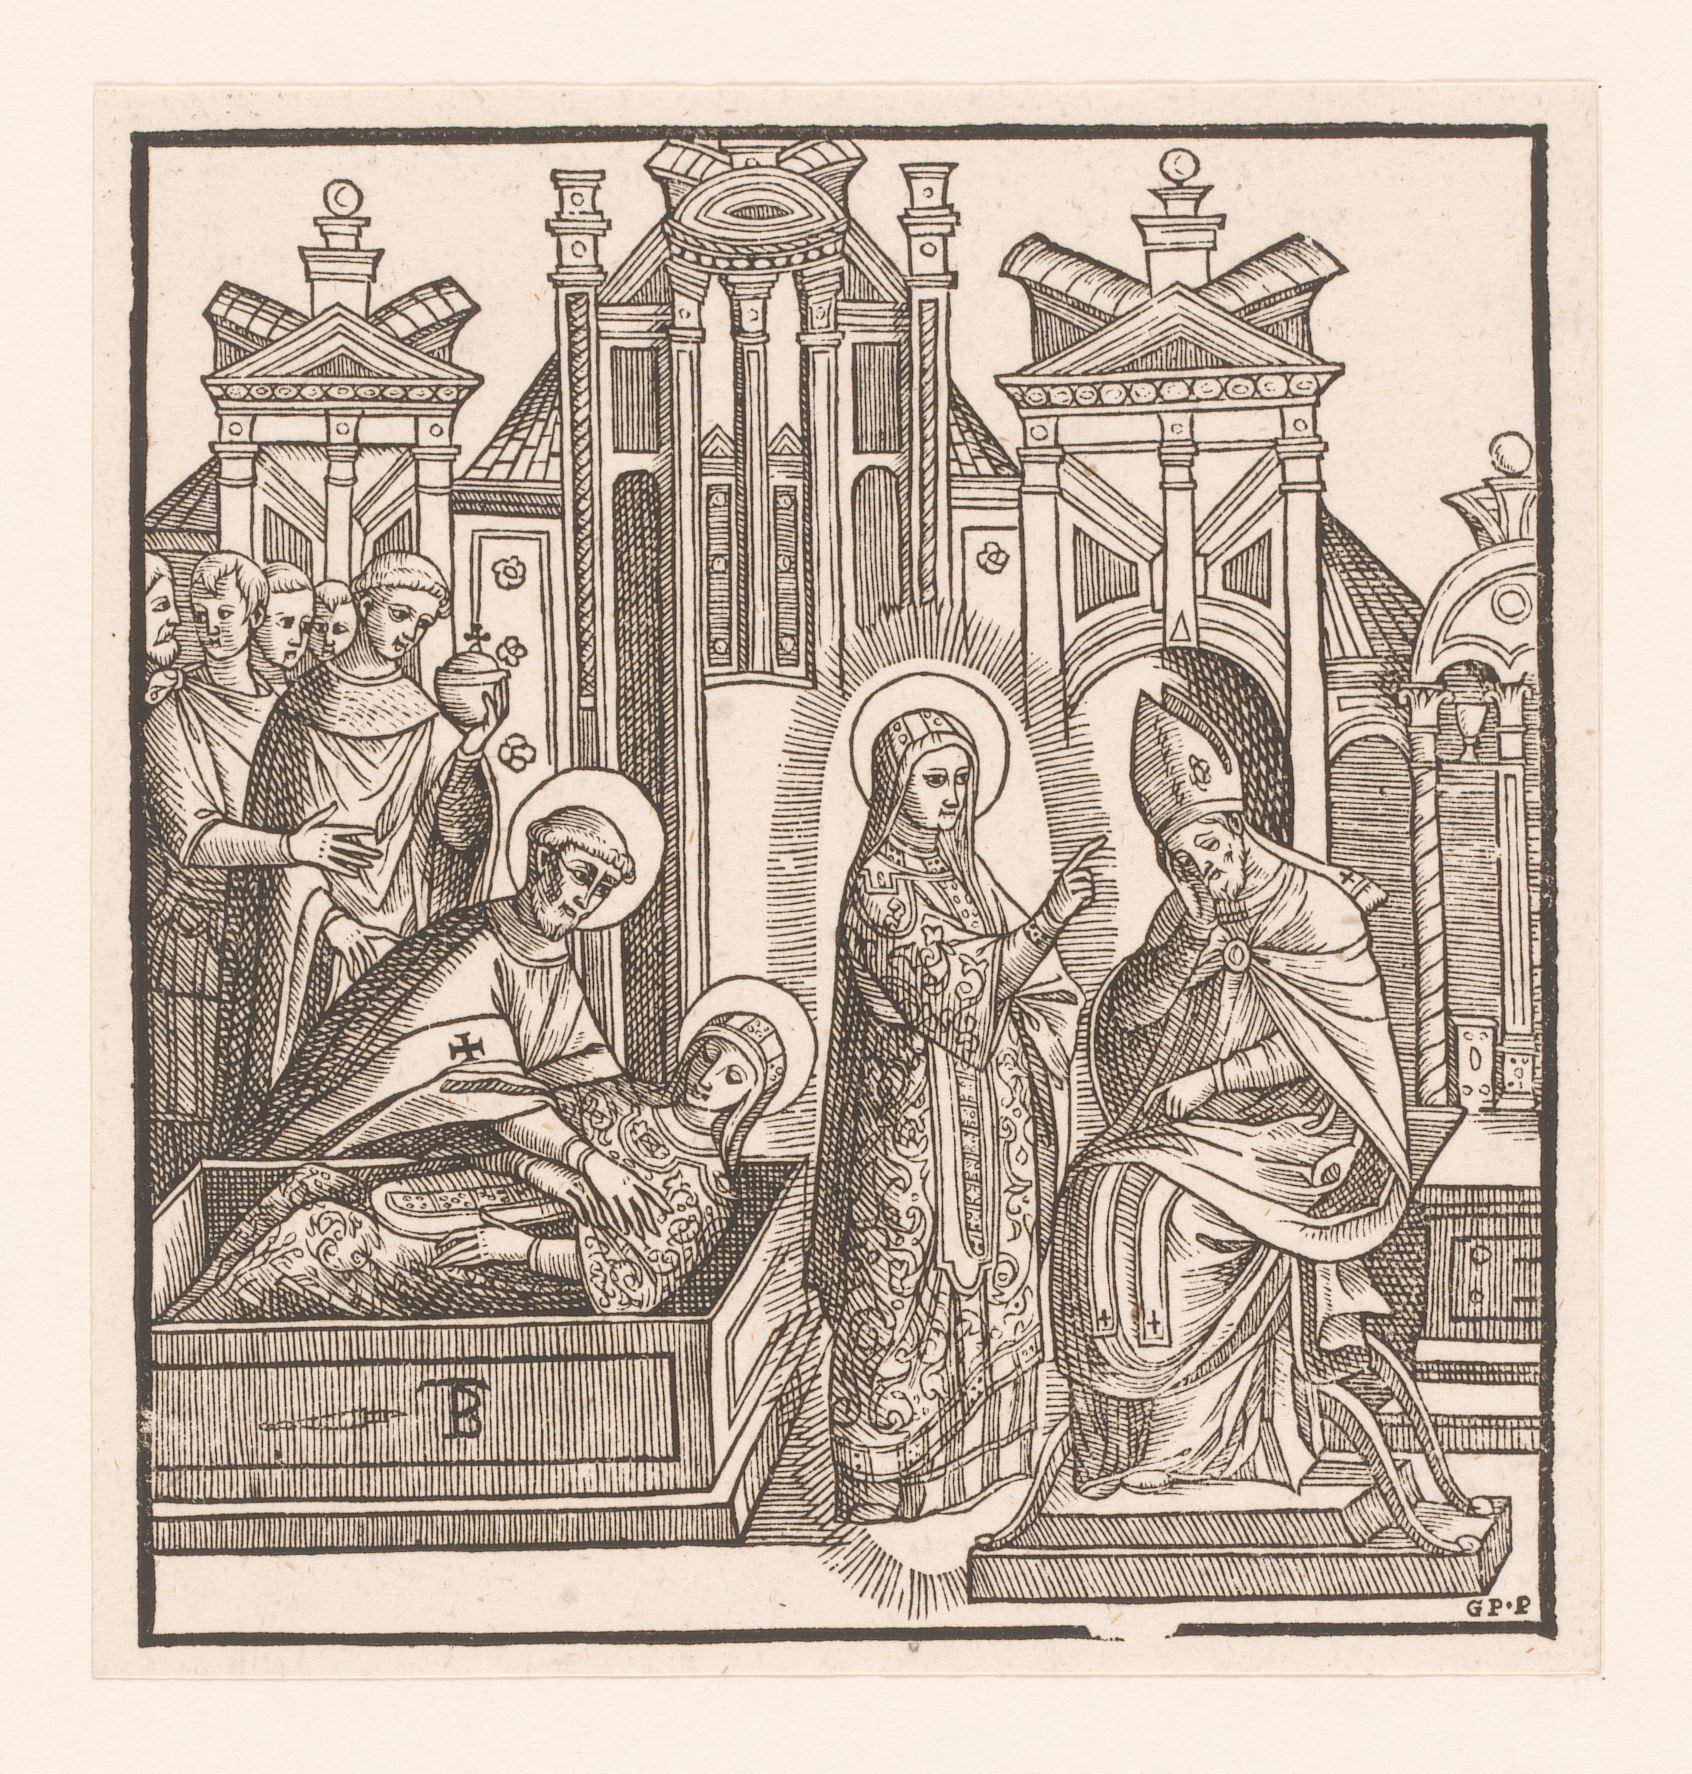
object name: print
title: Heilige troost een zittende bisschop en wordt ten grave gelegd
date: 1500-1599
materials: paper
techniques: woodcut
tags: archbishop, bishop, etc. (roman catholic), female saints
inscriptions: collector's mark: Lugt 2228